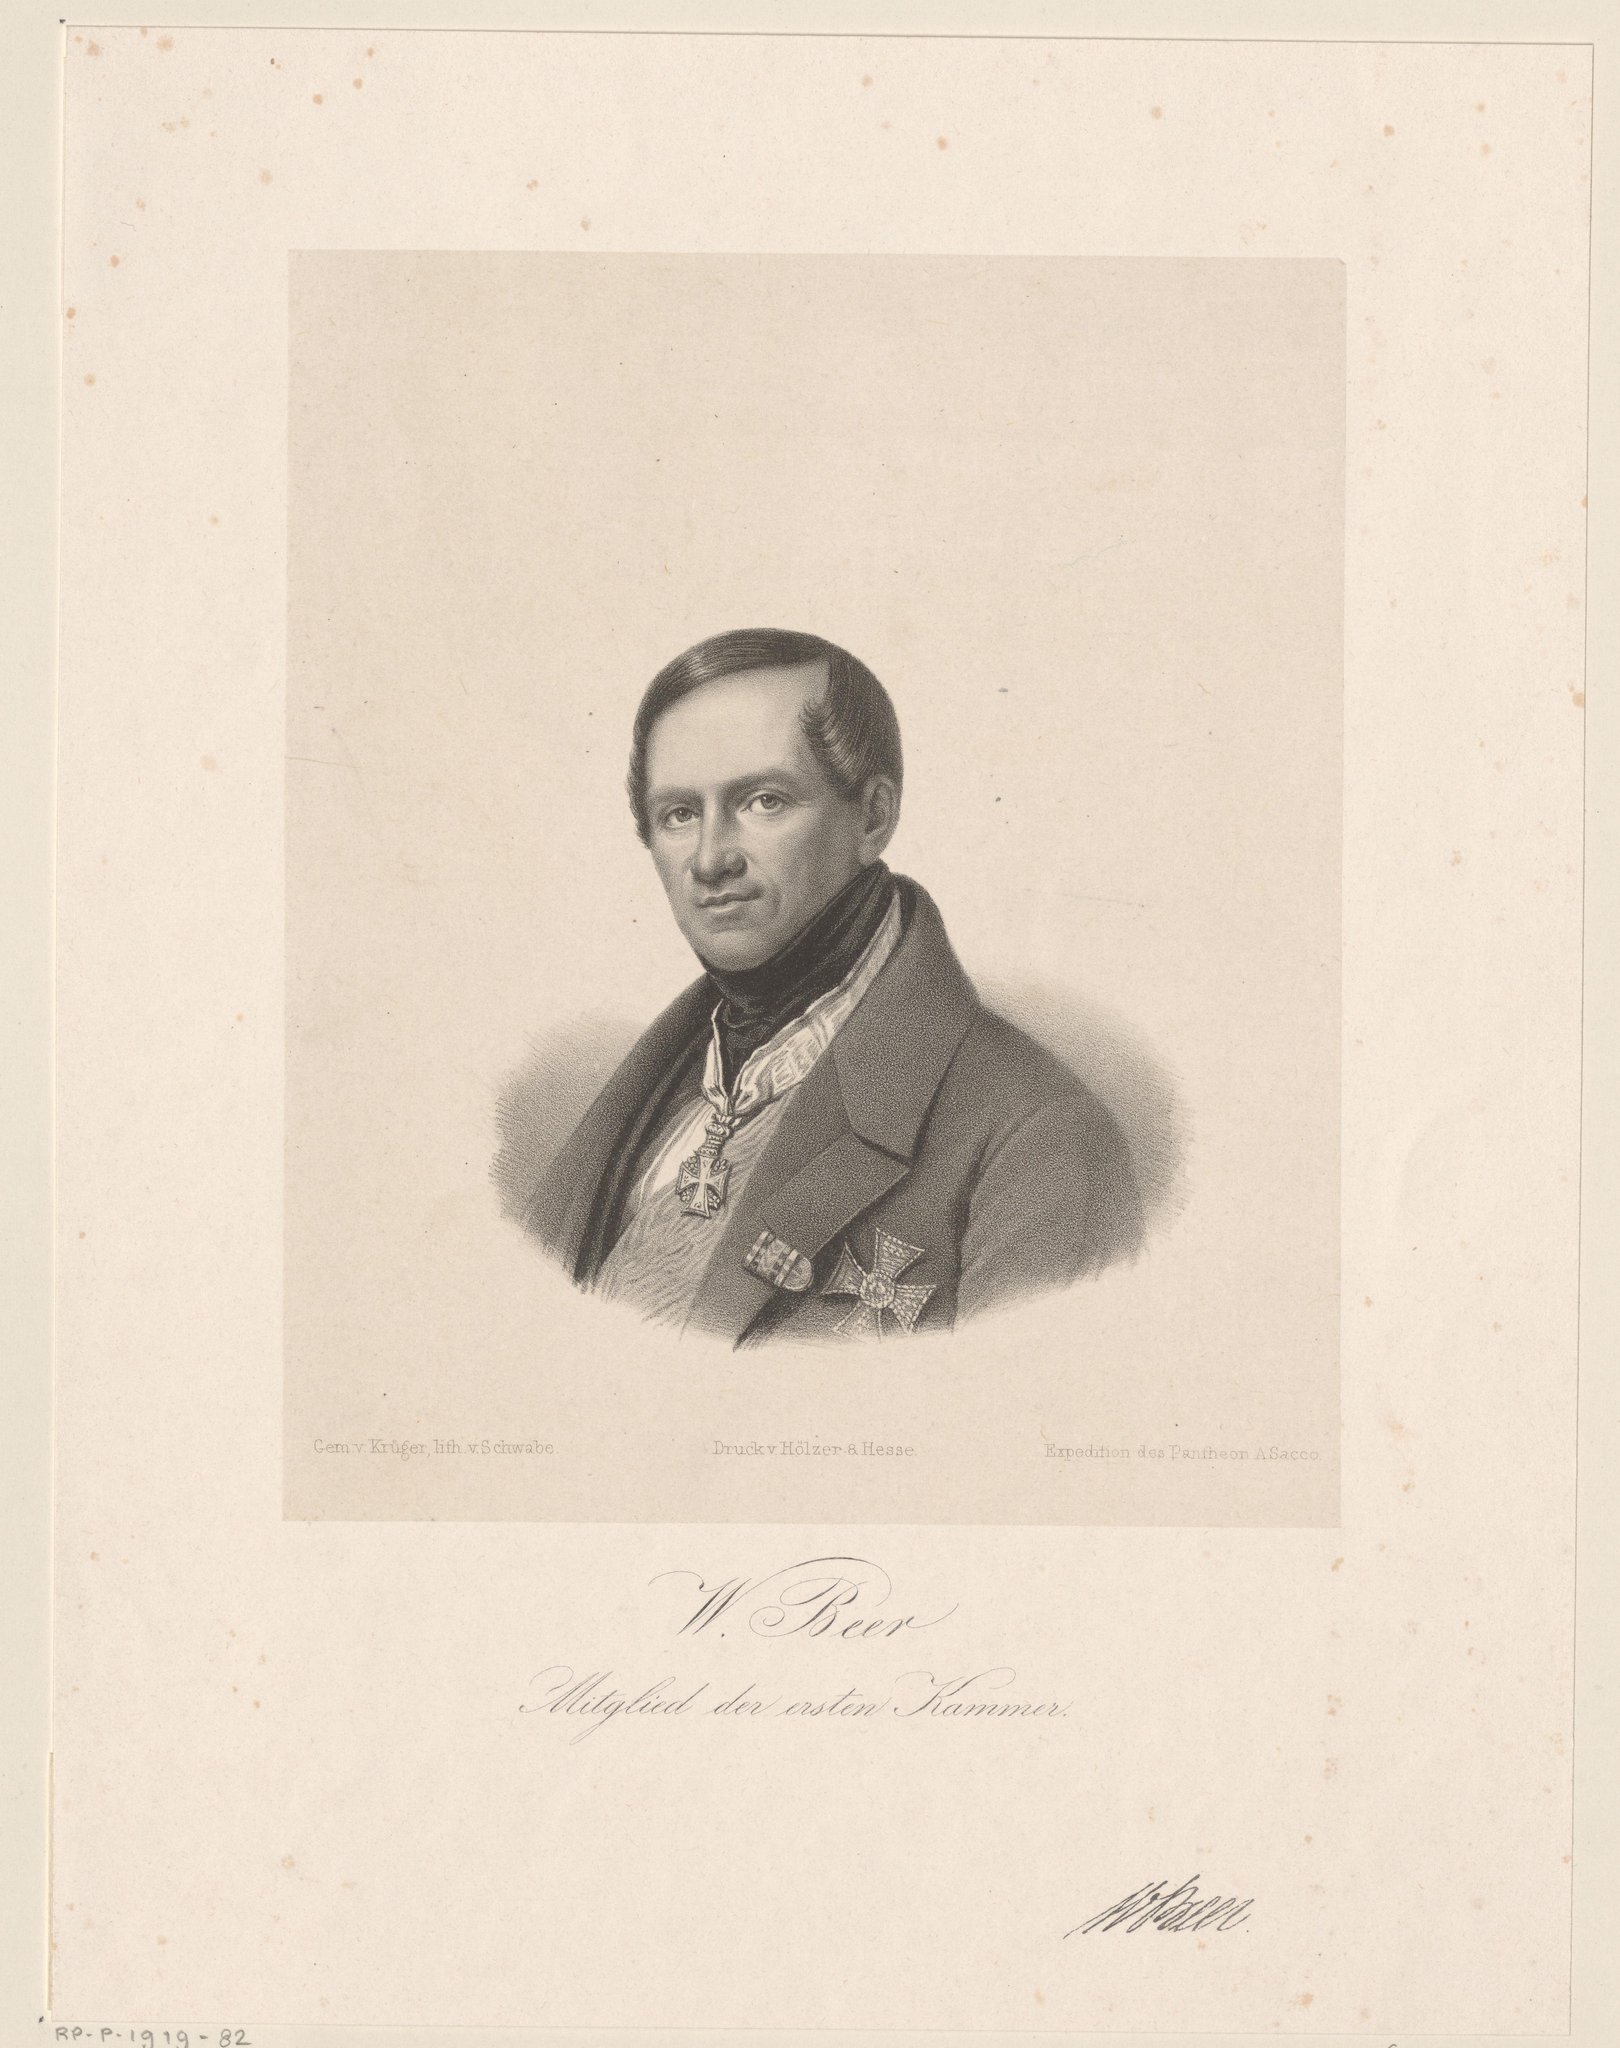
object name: print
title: Portret van Wilhelm Beer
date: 1825-1875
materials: paper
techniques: lithograph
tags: berlin, politician, historical persons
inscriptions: collector's mark: Lugt 2228